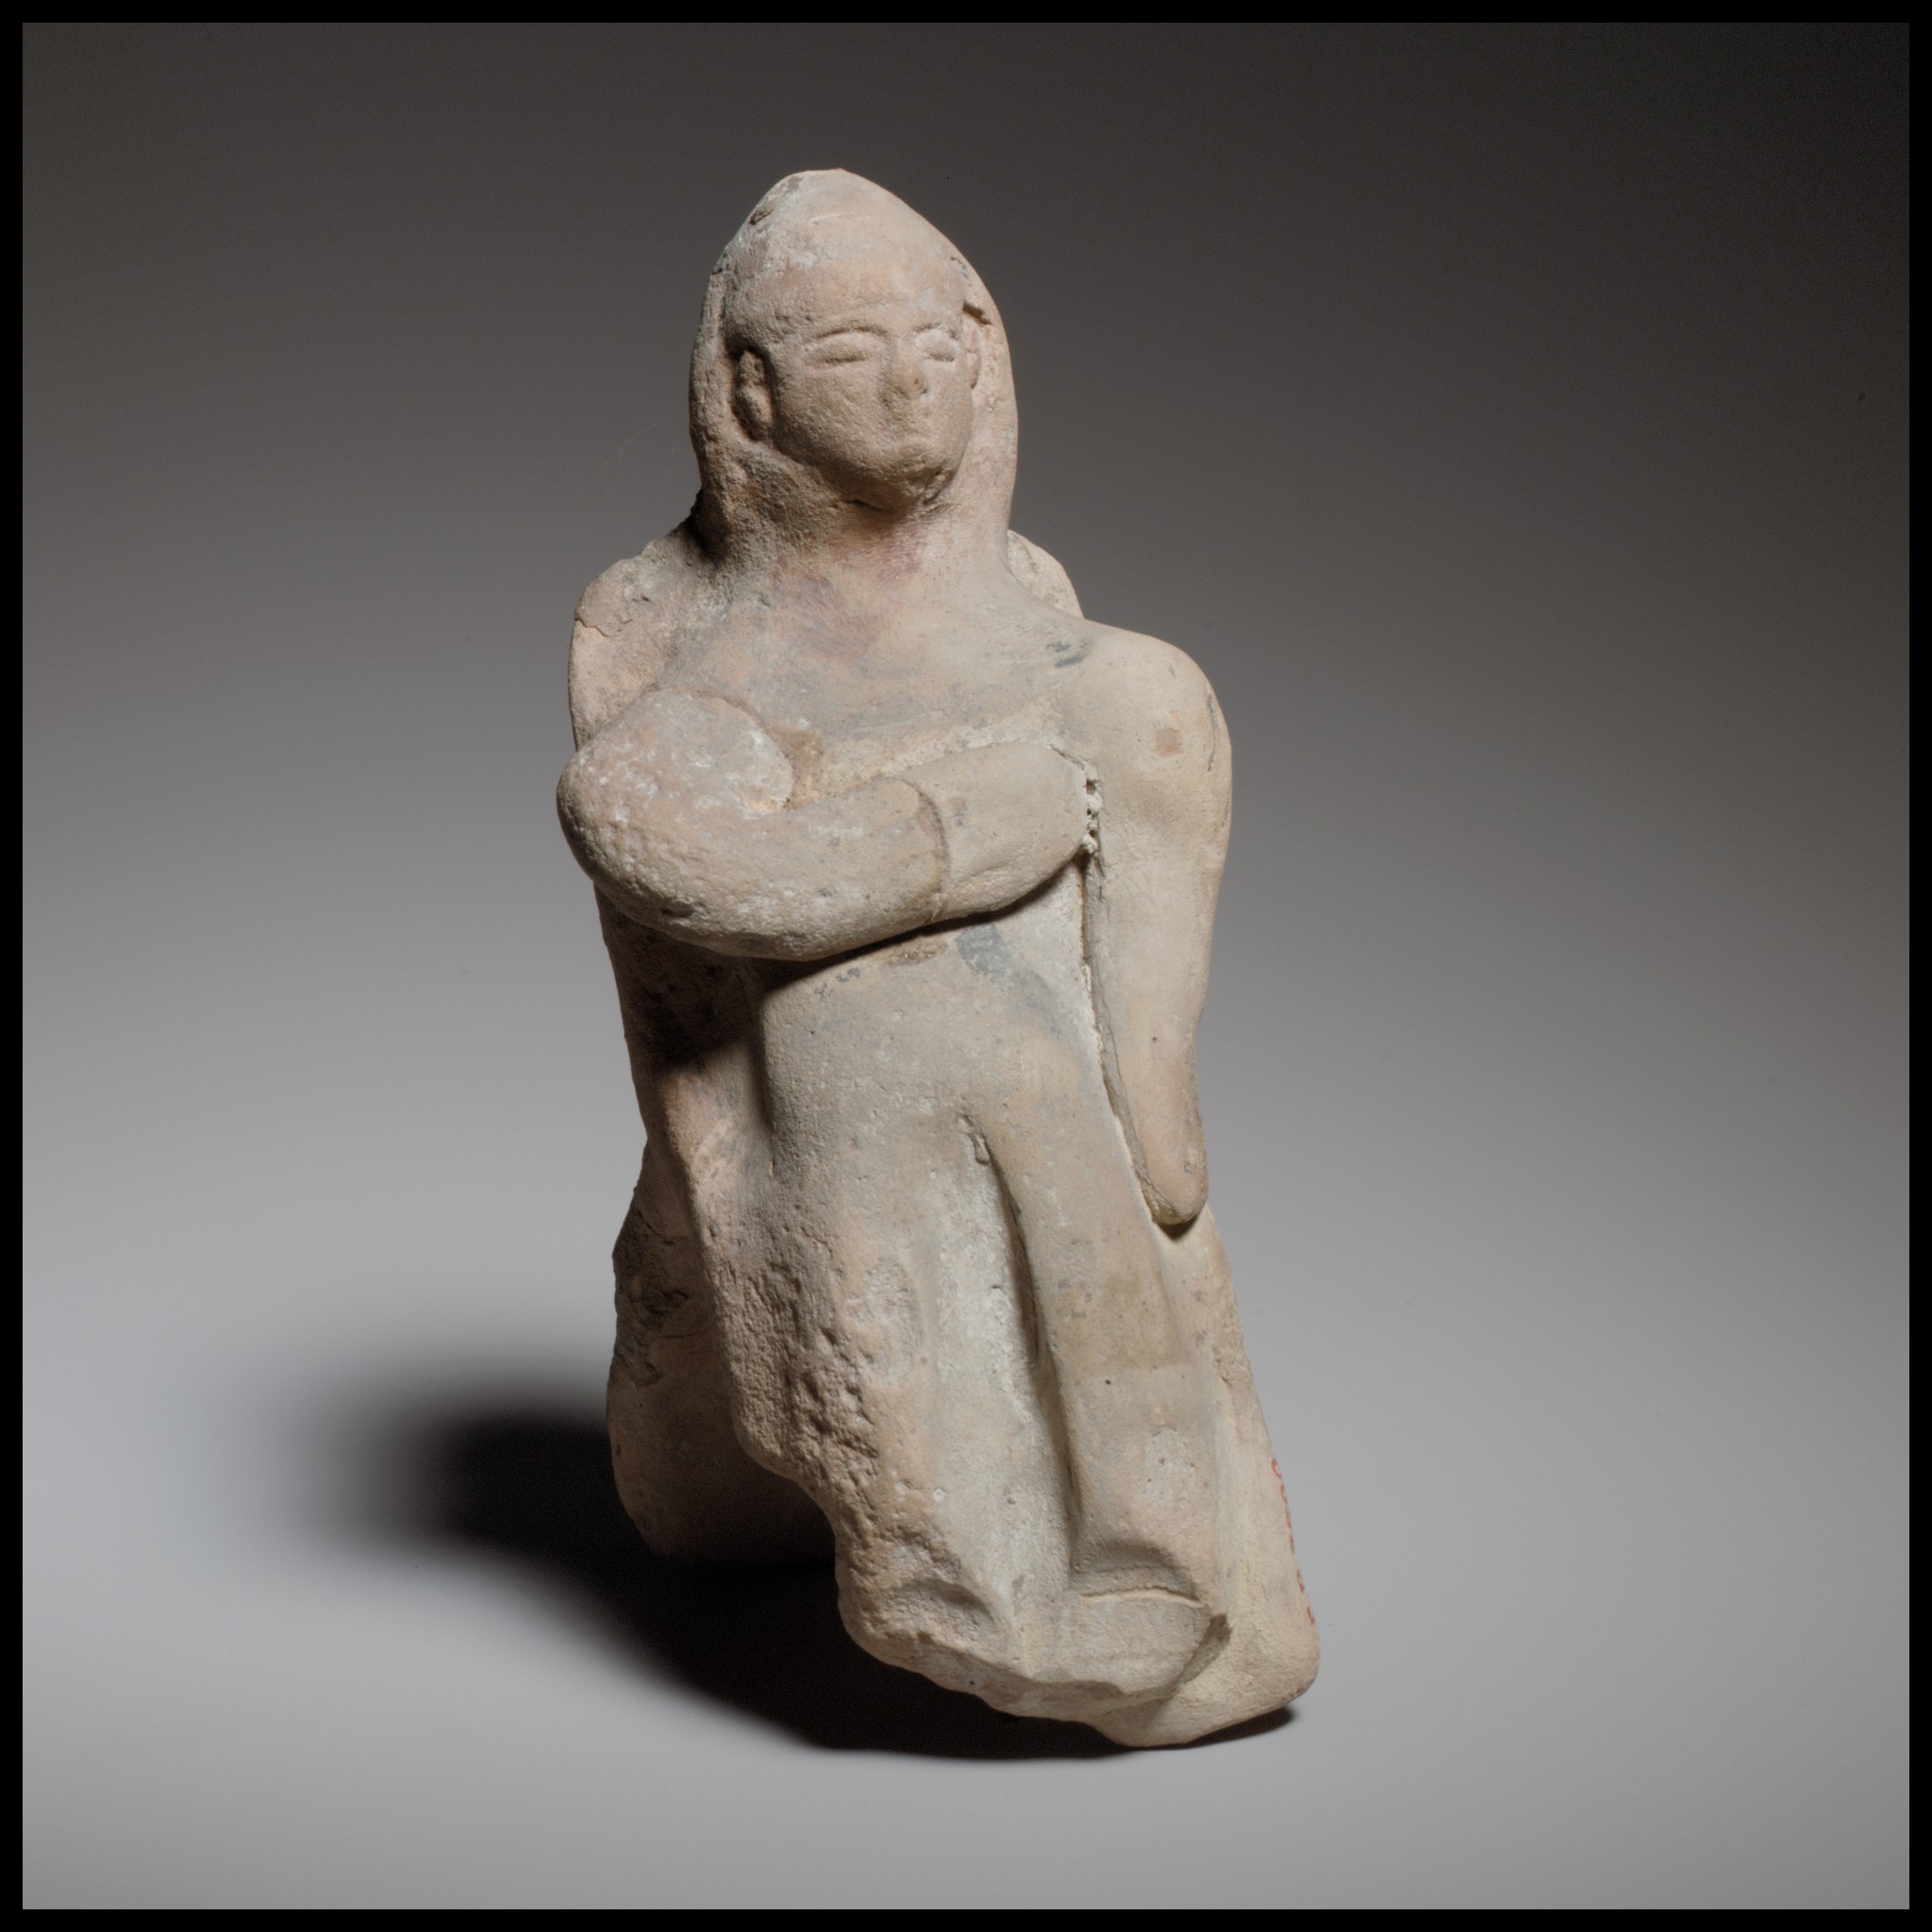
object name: statuette of a woman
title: Seated female figurine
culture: cypriot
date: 600-480 BCE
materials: terracotta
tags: women